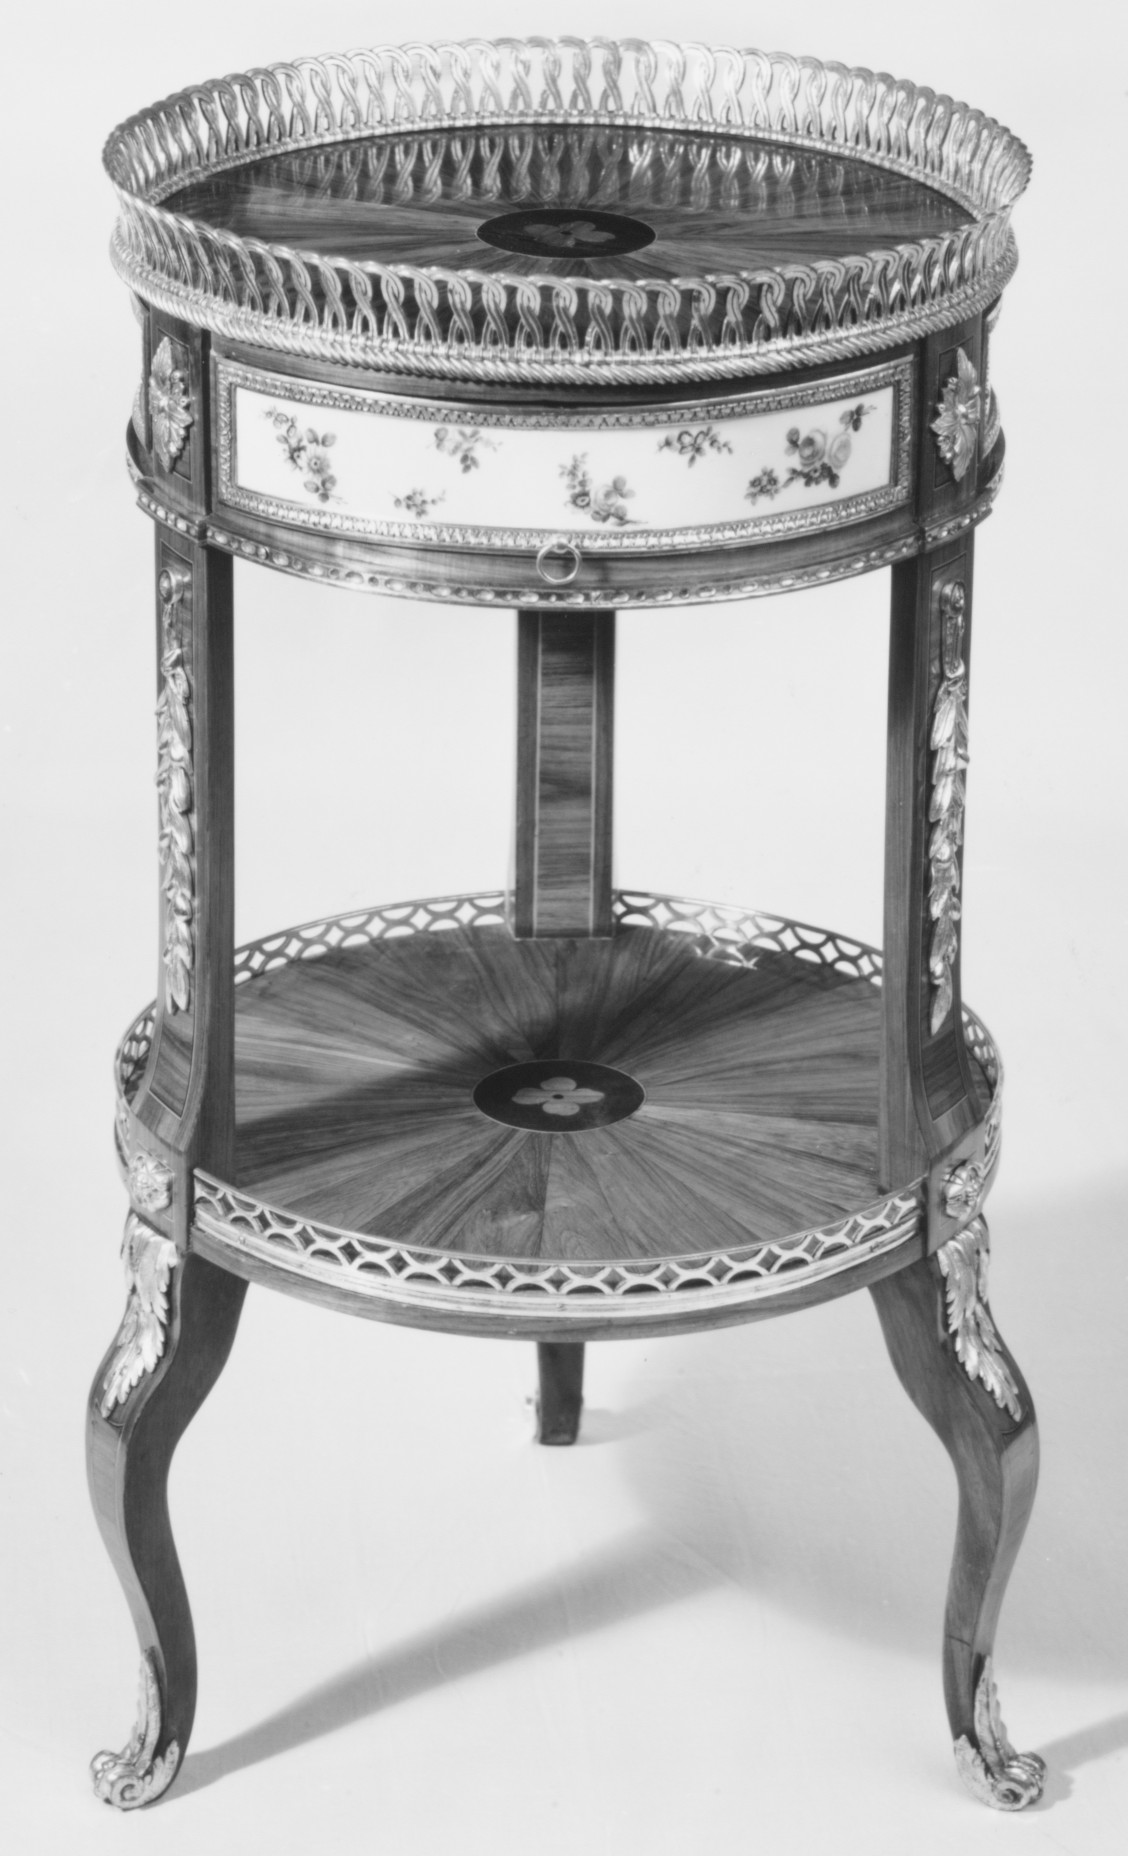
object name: work table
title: Circular worktable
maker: martin carlin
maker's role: maker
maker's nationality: french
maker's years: 1725-1785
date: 1772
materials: wood, gilt bronze, soft paste porcelain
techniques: veneering